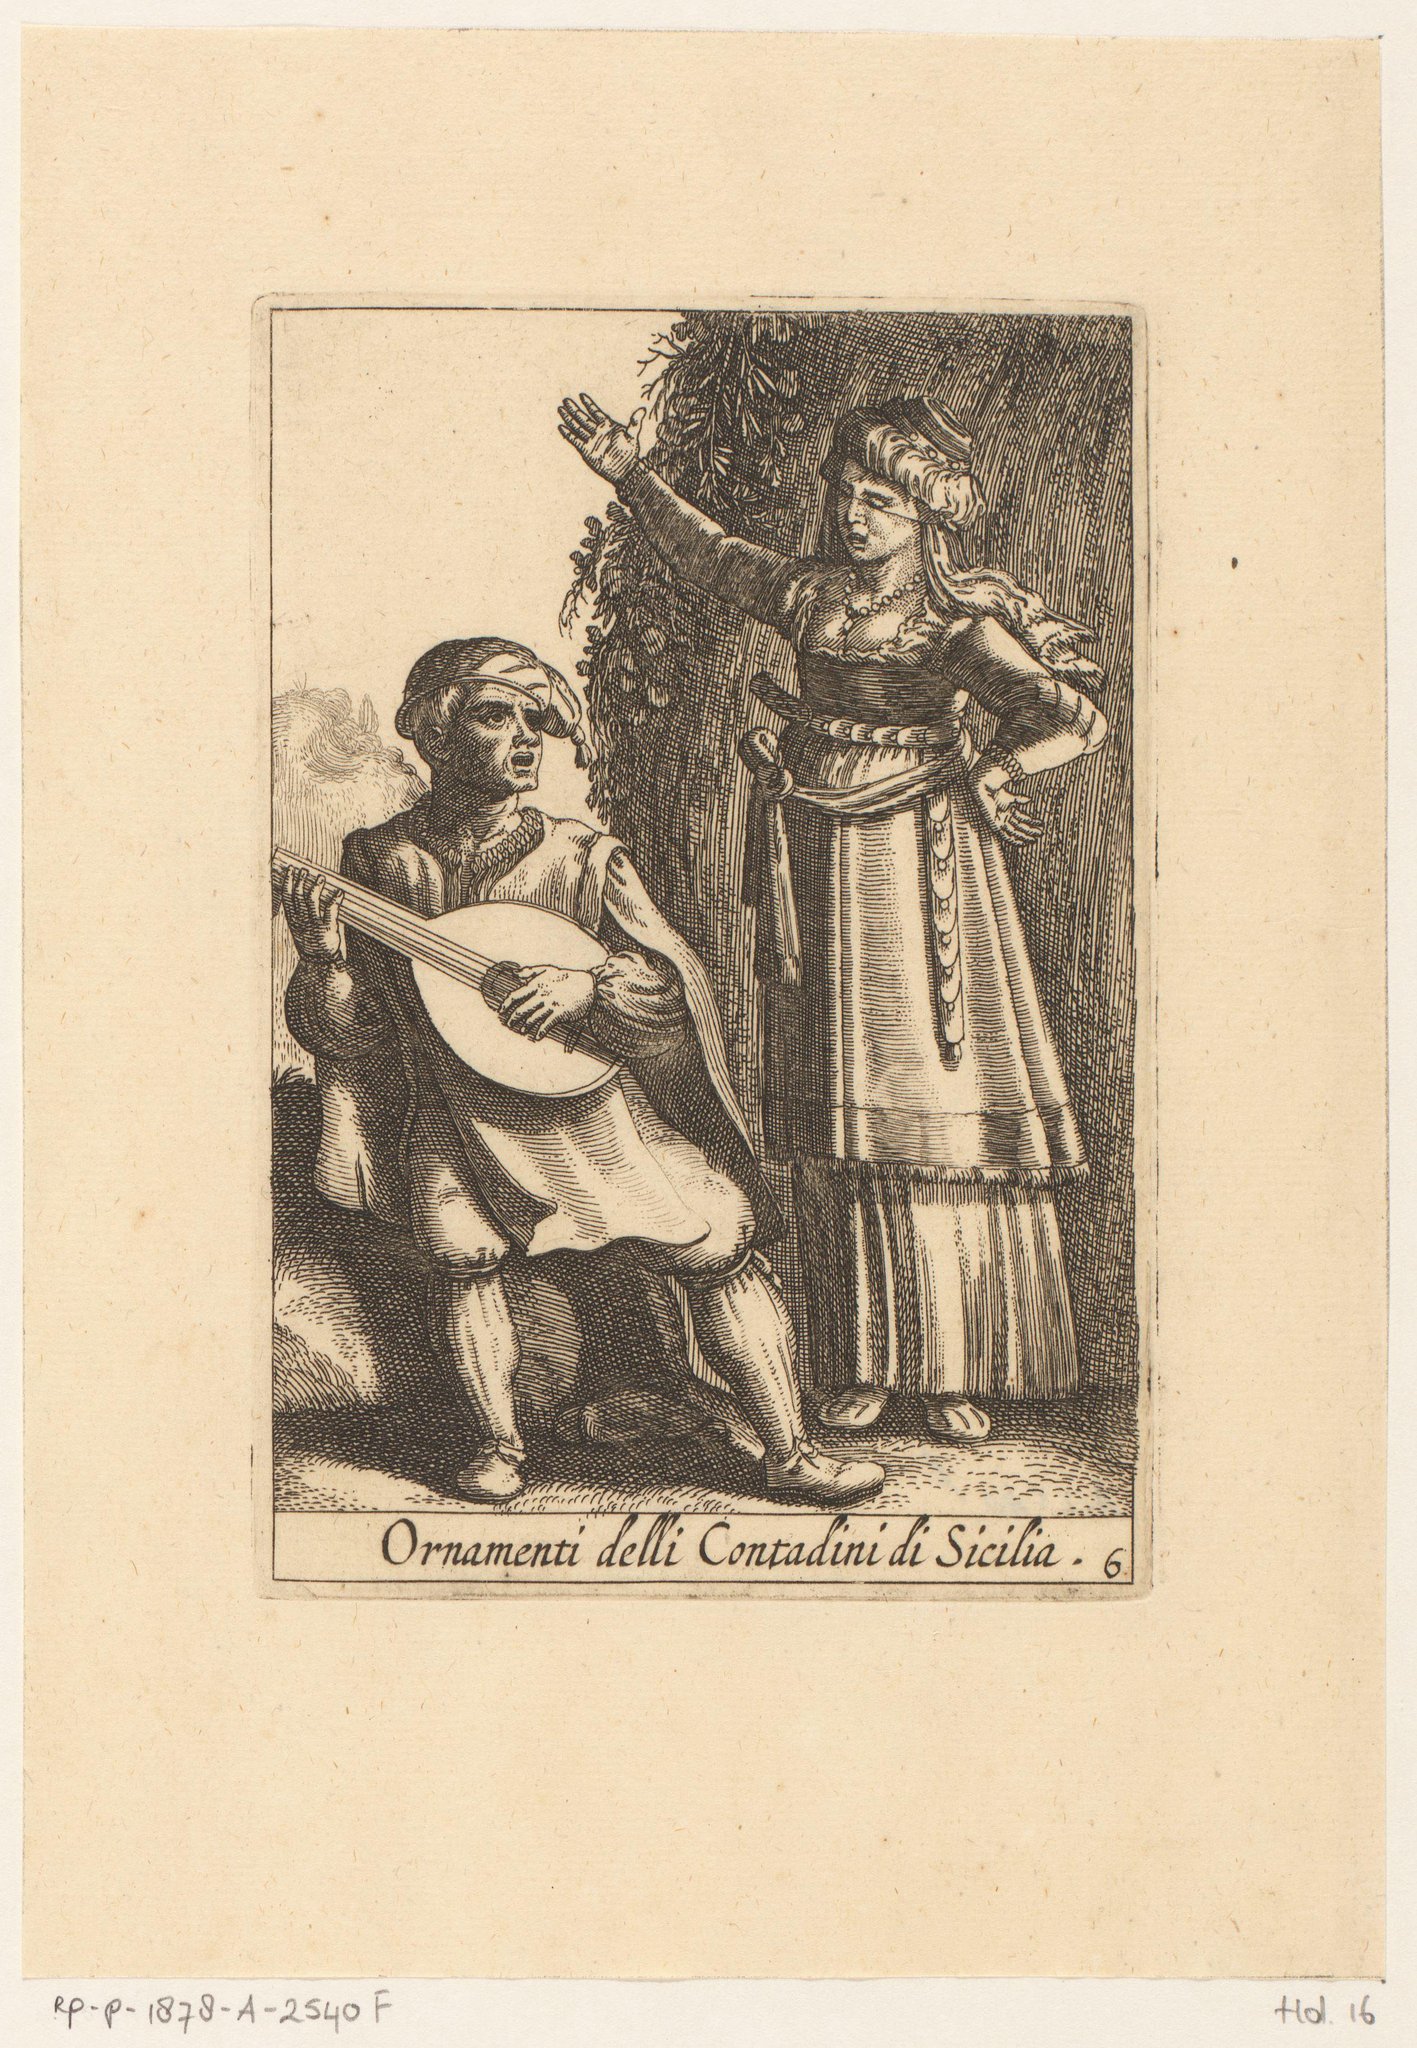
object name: print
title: Ornamenti delli Contadini di Sicilia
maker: Anonymous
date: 1720-1772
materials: paper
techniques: etching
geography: amsterdam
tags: musician(s) accompanying singer(s), europeans (with name) (+ costume)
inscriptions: collector's mark: Lugt 2228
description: Een boerenpaar gekleed in mode uit Sicilië, Italië. Het paar is ten voeten uit weergegeven. De zittende man bespeelt de luit, zijn hoofd is getooid met een baret. Hij begeleidt de zingende vrouw die naast hem staat. De vrouw draagt een japon met riem, haar hoofd is gedeeltelijk bedekt met een klein hoofddeksel waaraan een sluier is bevestigd. De prent maakt deel uit van een twaalfdelige serie prenten met Italiaanse kostuums.